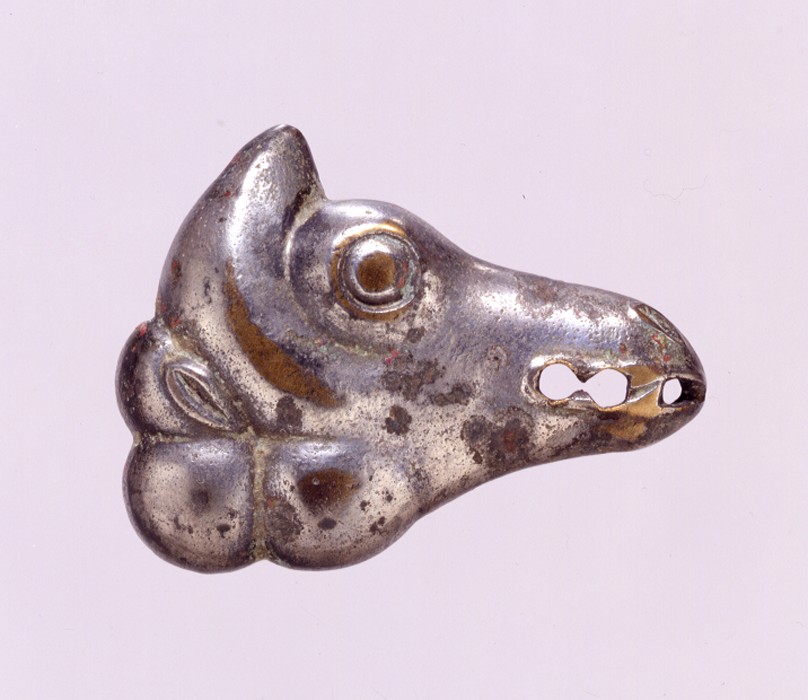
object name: harness ornament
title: Harness Ornament in the Shape of a Camel's Head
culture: northwest chinese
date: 400-201 BCE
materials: bronze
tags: camels